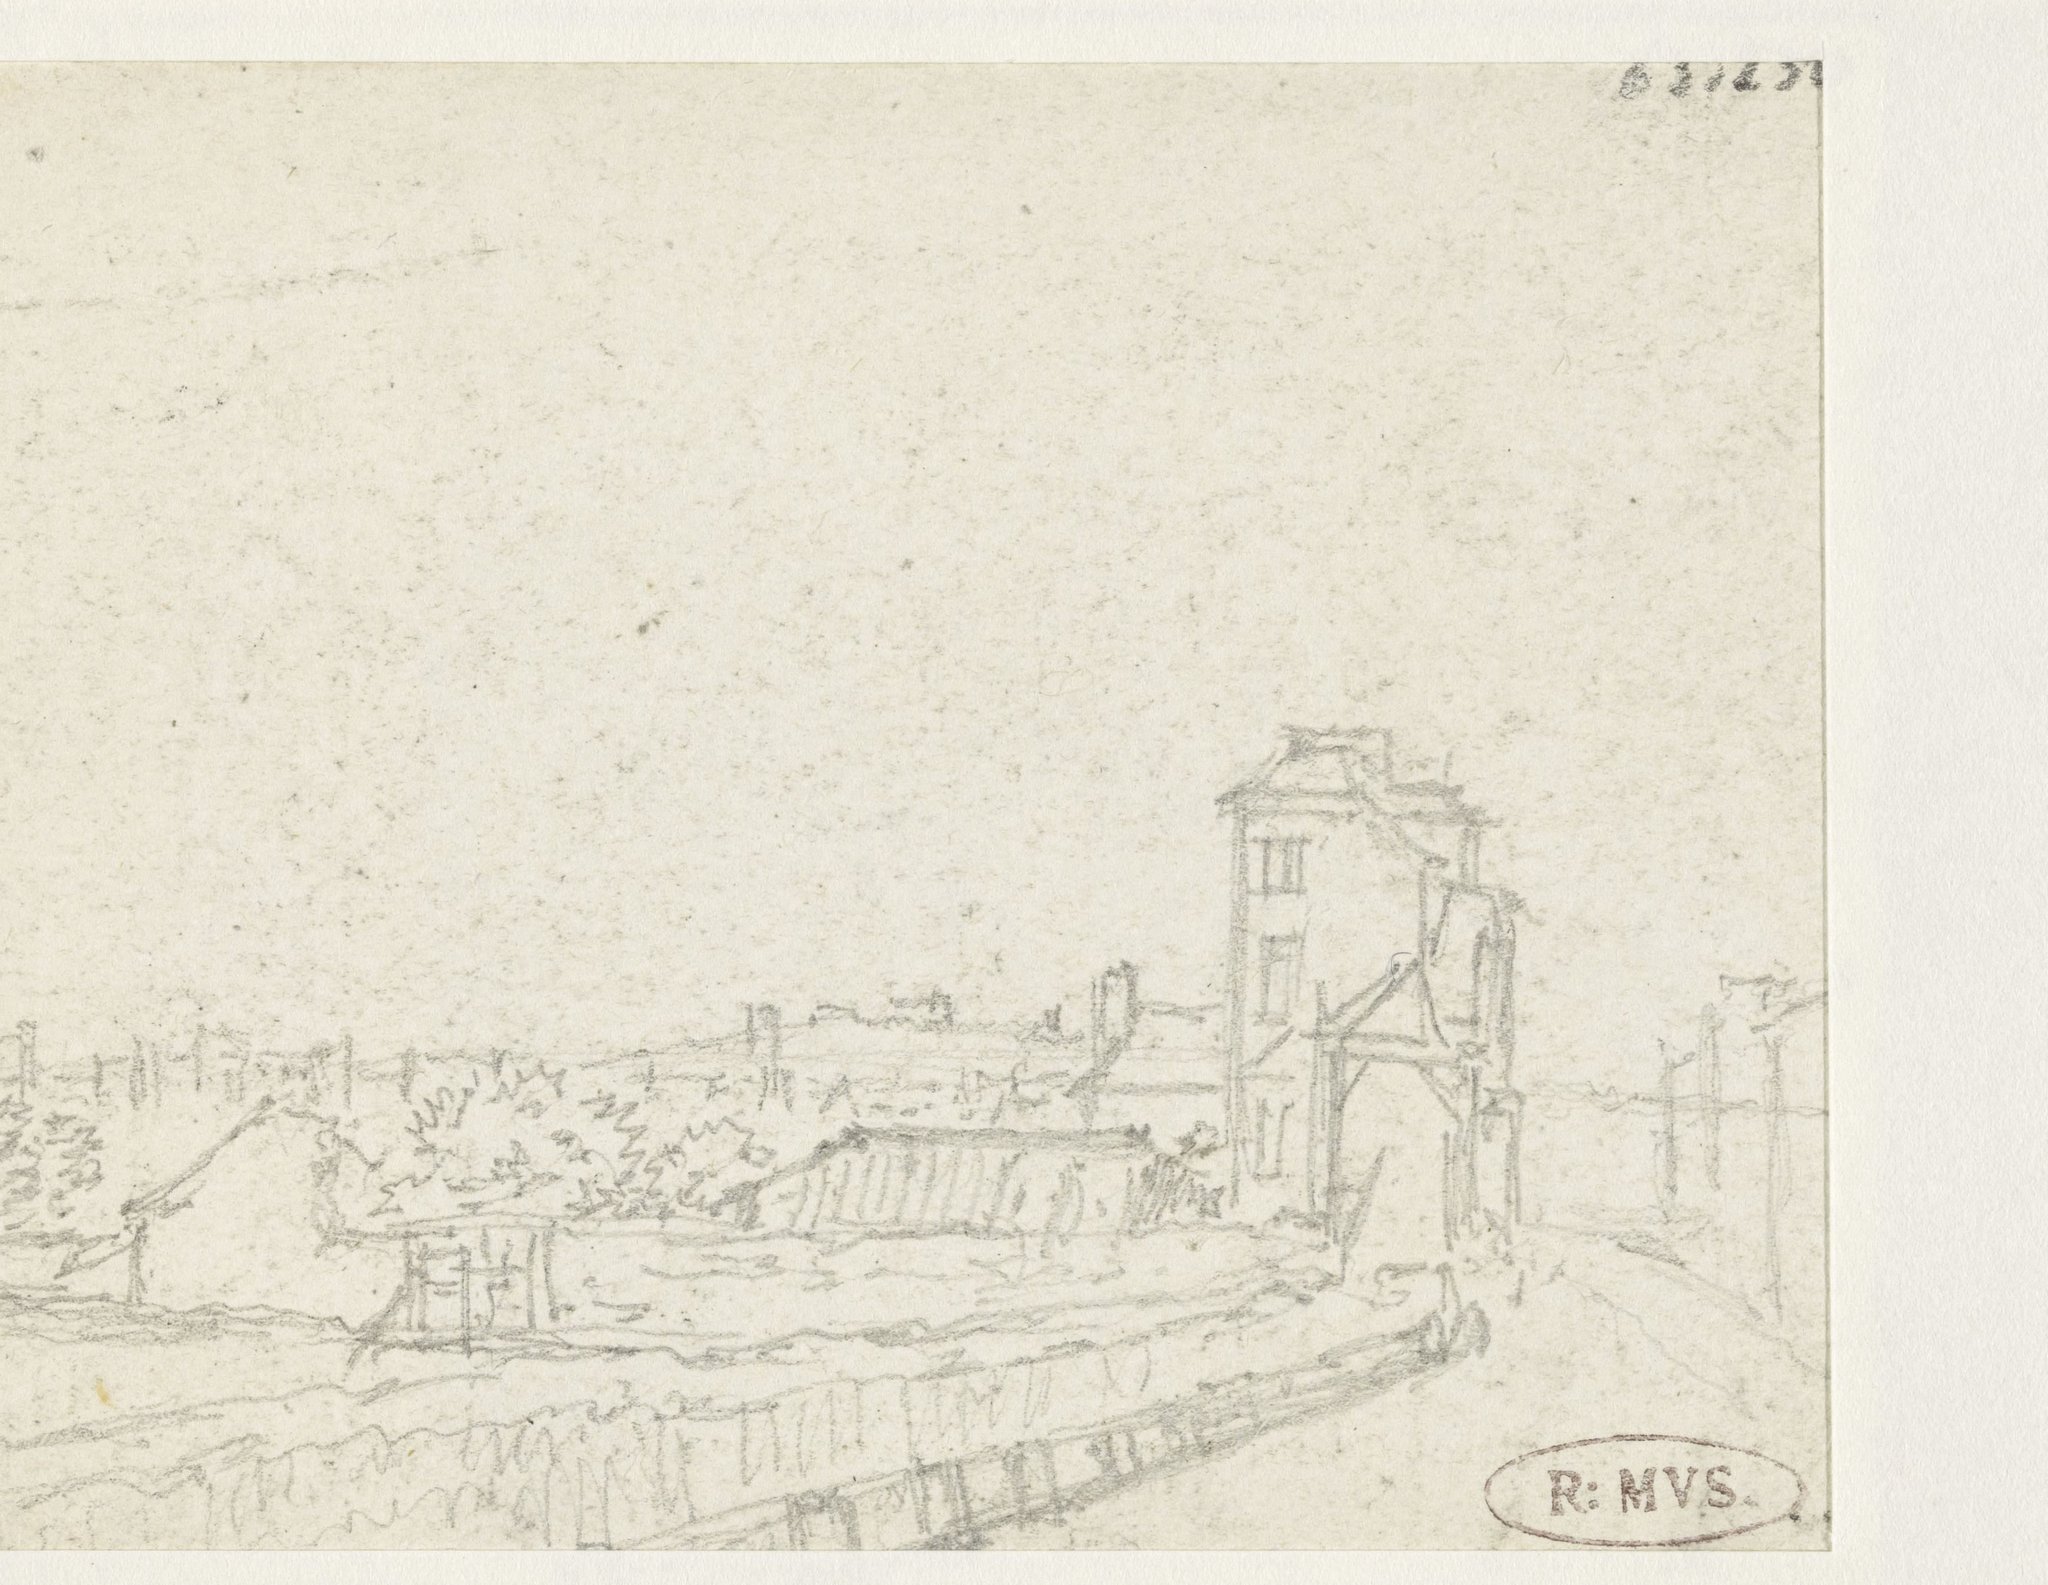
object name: drawing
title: Begin van de stad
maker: georges michel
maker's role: draughtsman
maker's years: 1763-1843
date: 1773-1843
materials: paper, pencil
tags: outskirts of city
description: Een van 120 tekeningen, afkomstig uit een 19e eeuws album met tekeningen van Georges Michel.